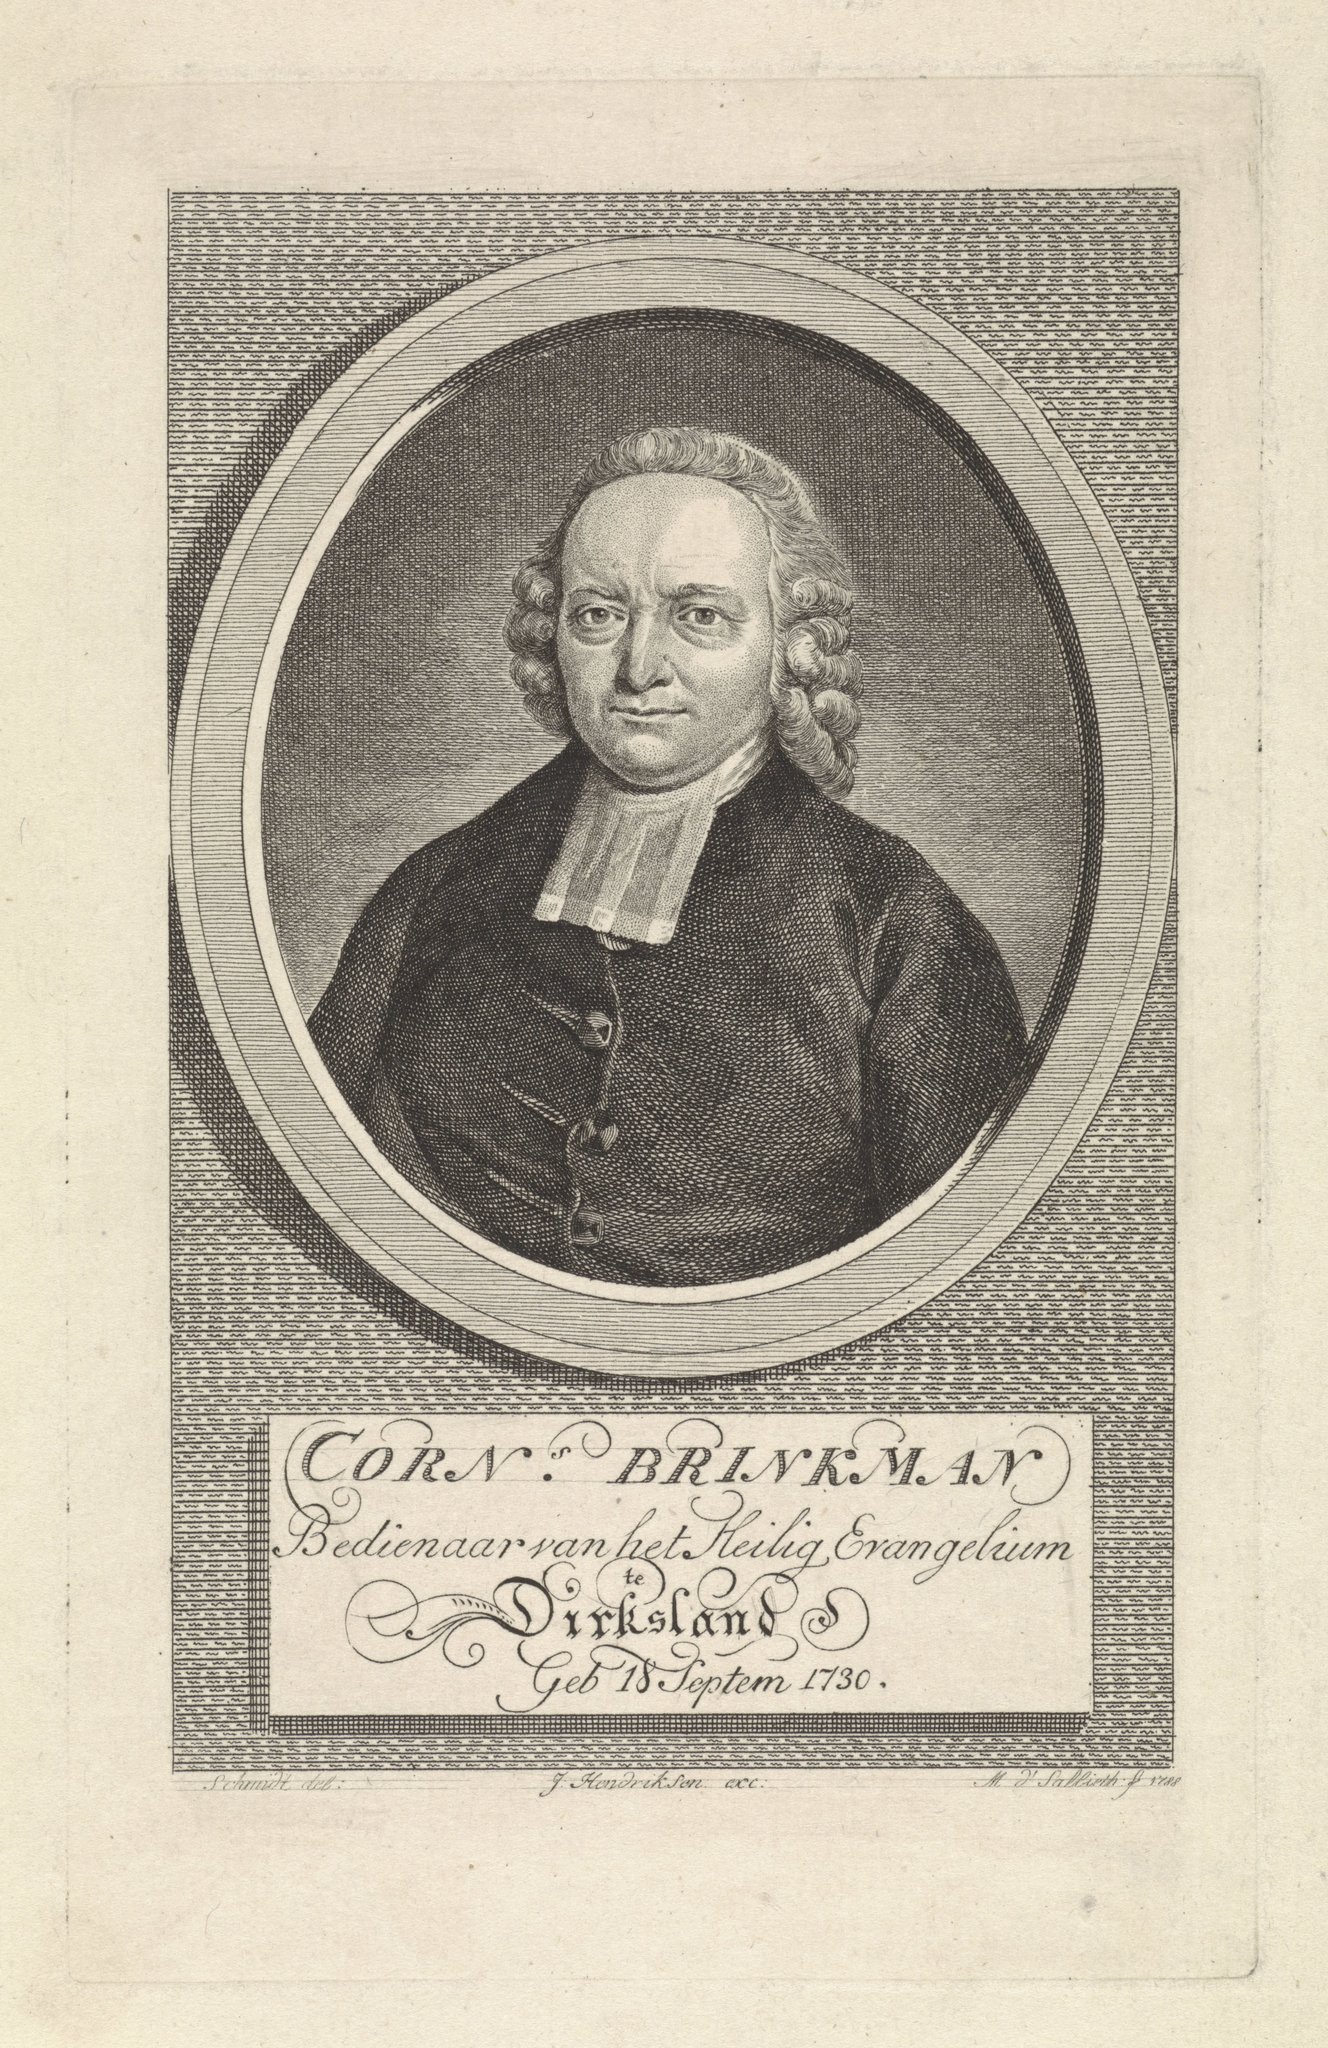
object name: print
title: Portret van de predikant Cornelis Brinkman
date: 1788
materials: paper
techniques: engraving, etching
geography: rotterdam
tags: cornelis brinkman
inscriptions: collector's mark: Lugt 2228